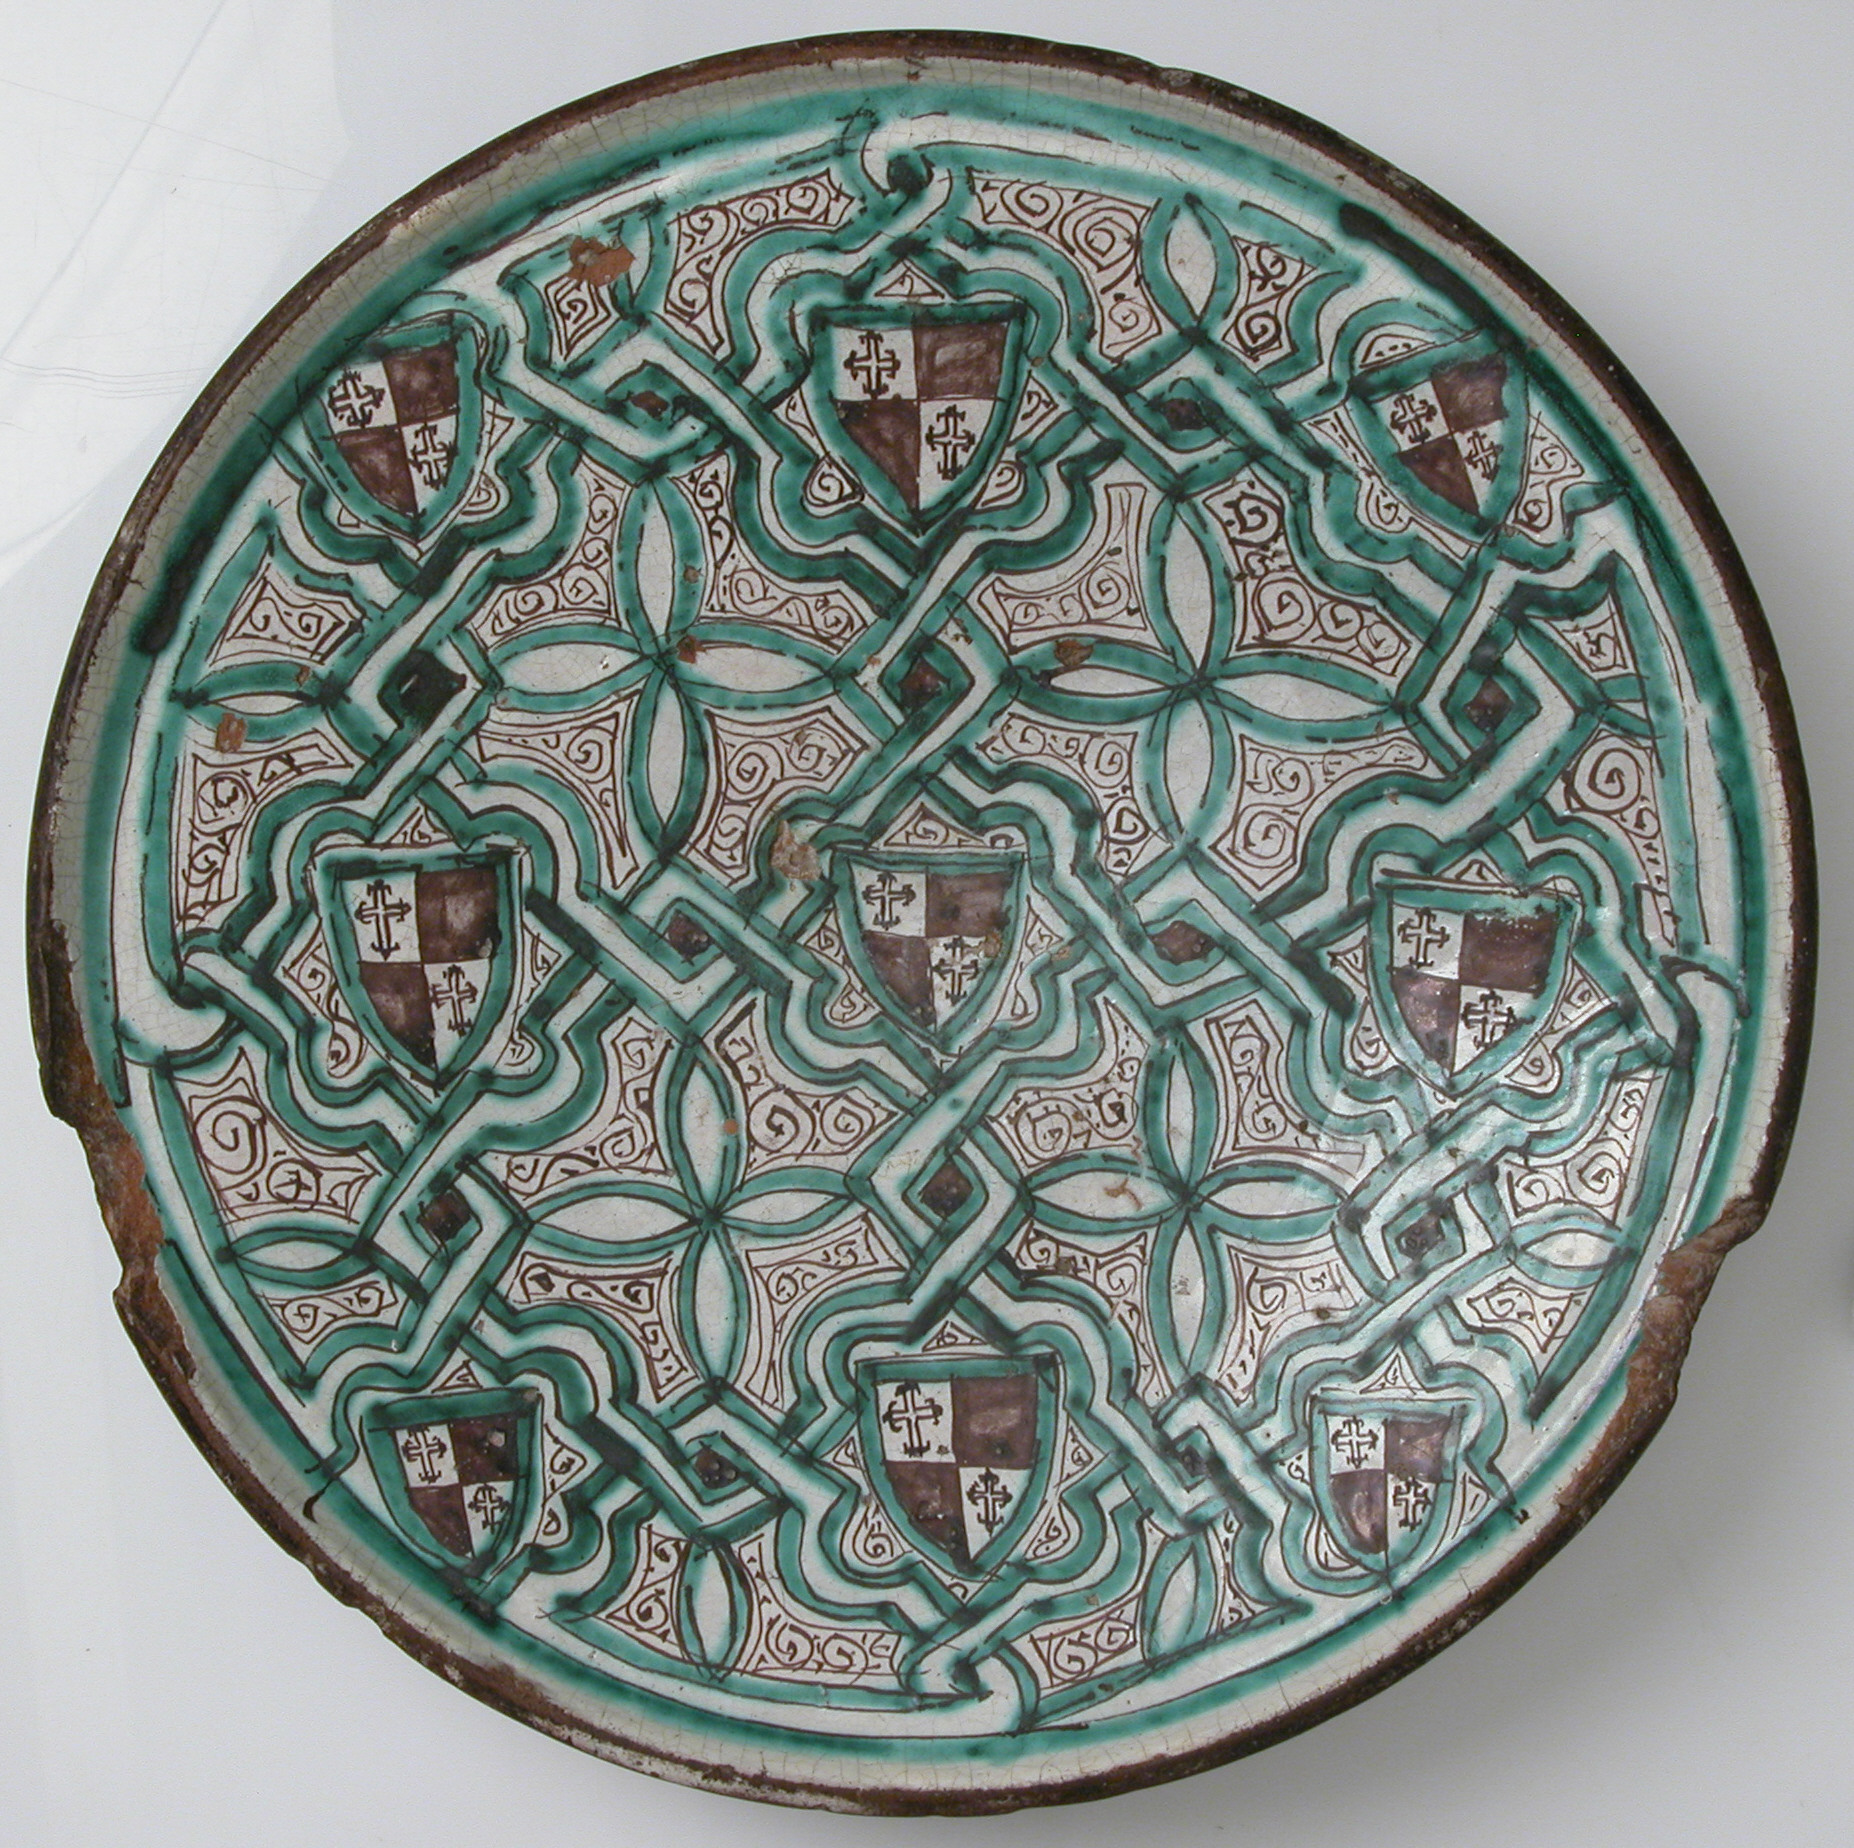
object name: dish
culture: spanish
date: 1301-1400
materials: earthenware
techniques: glazing